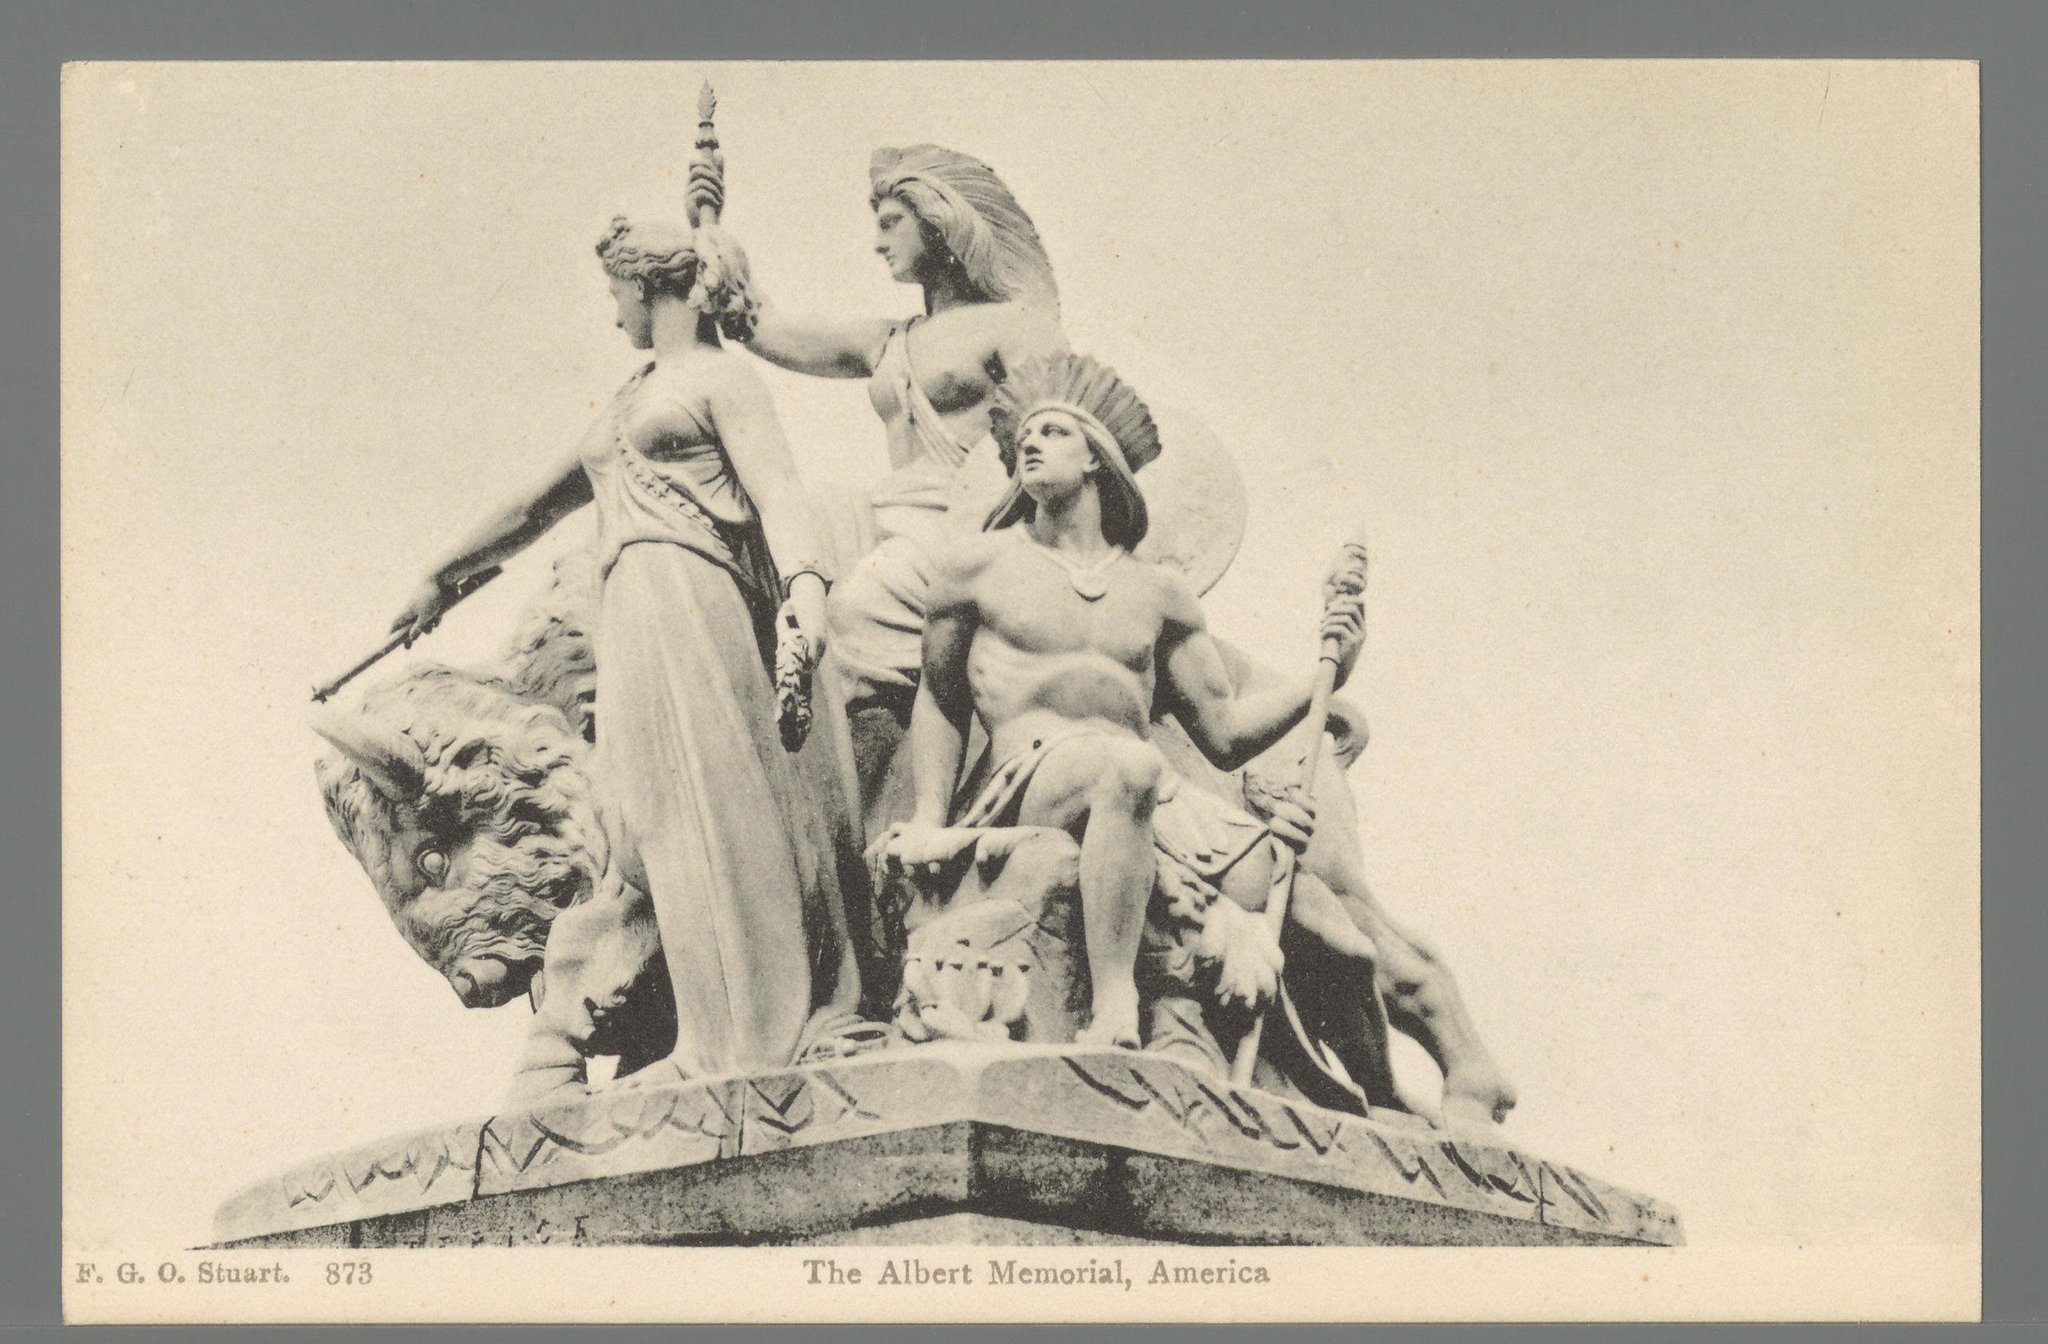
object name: photomechanical print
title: The Albert Memorial, America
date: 1902-1930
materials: cardboard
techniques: photograph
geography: london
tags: america represented allegorically; 'america' (ripa), monument, statue, hoofed animals: bison